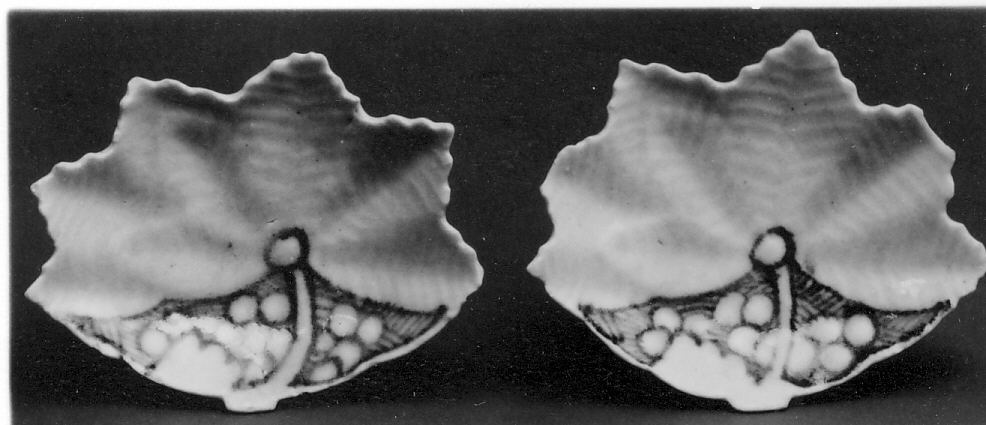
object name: dish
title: Dish in a Leaf Shape with Wave and Molded Double Leaf Design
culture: japanese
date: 1634-1666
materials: porcelain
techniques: underglaze